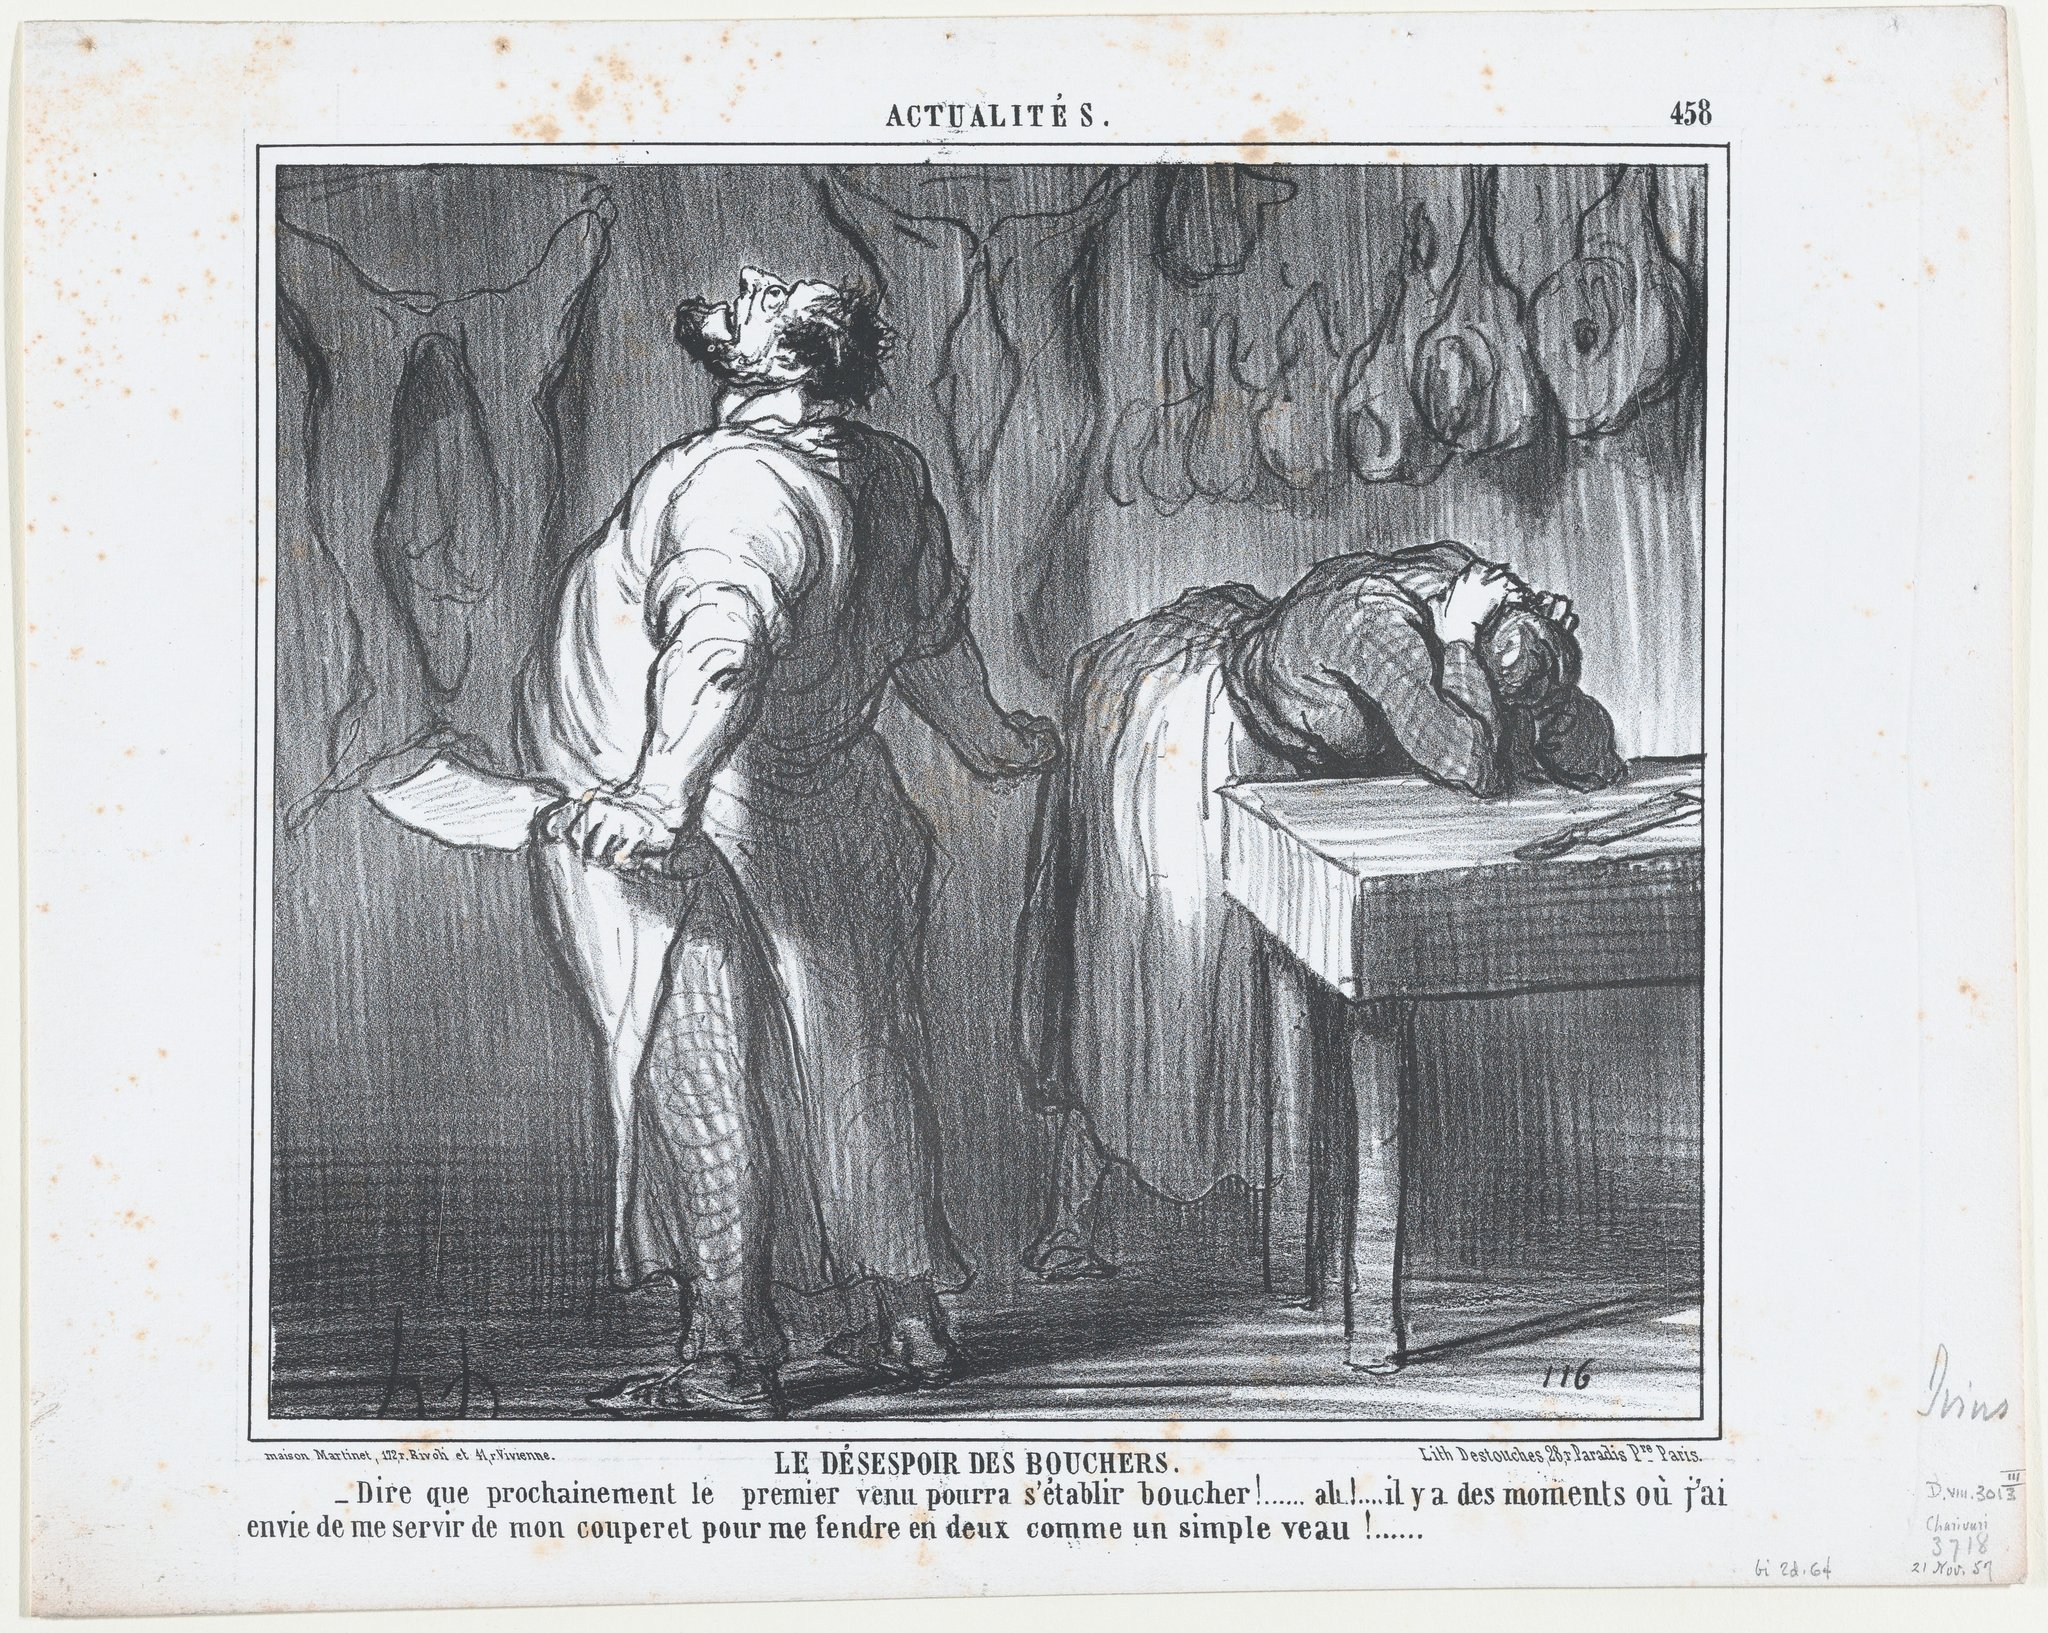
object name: print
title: Le Désespoir des Bouchers, from Actualités, published in Le Charivari, November 21, 1857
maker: honoré daumier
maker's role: artist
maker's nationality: french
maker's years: 1808-1879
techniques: lithograph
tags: men,women,butchers